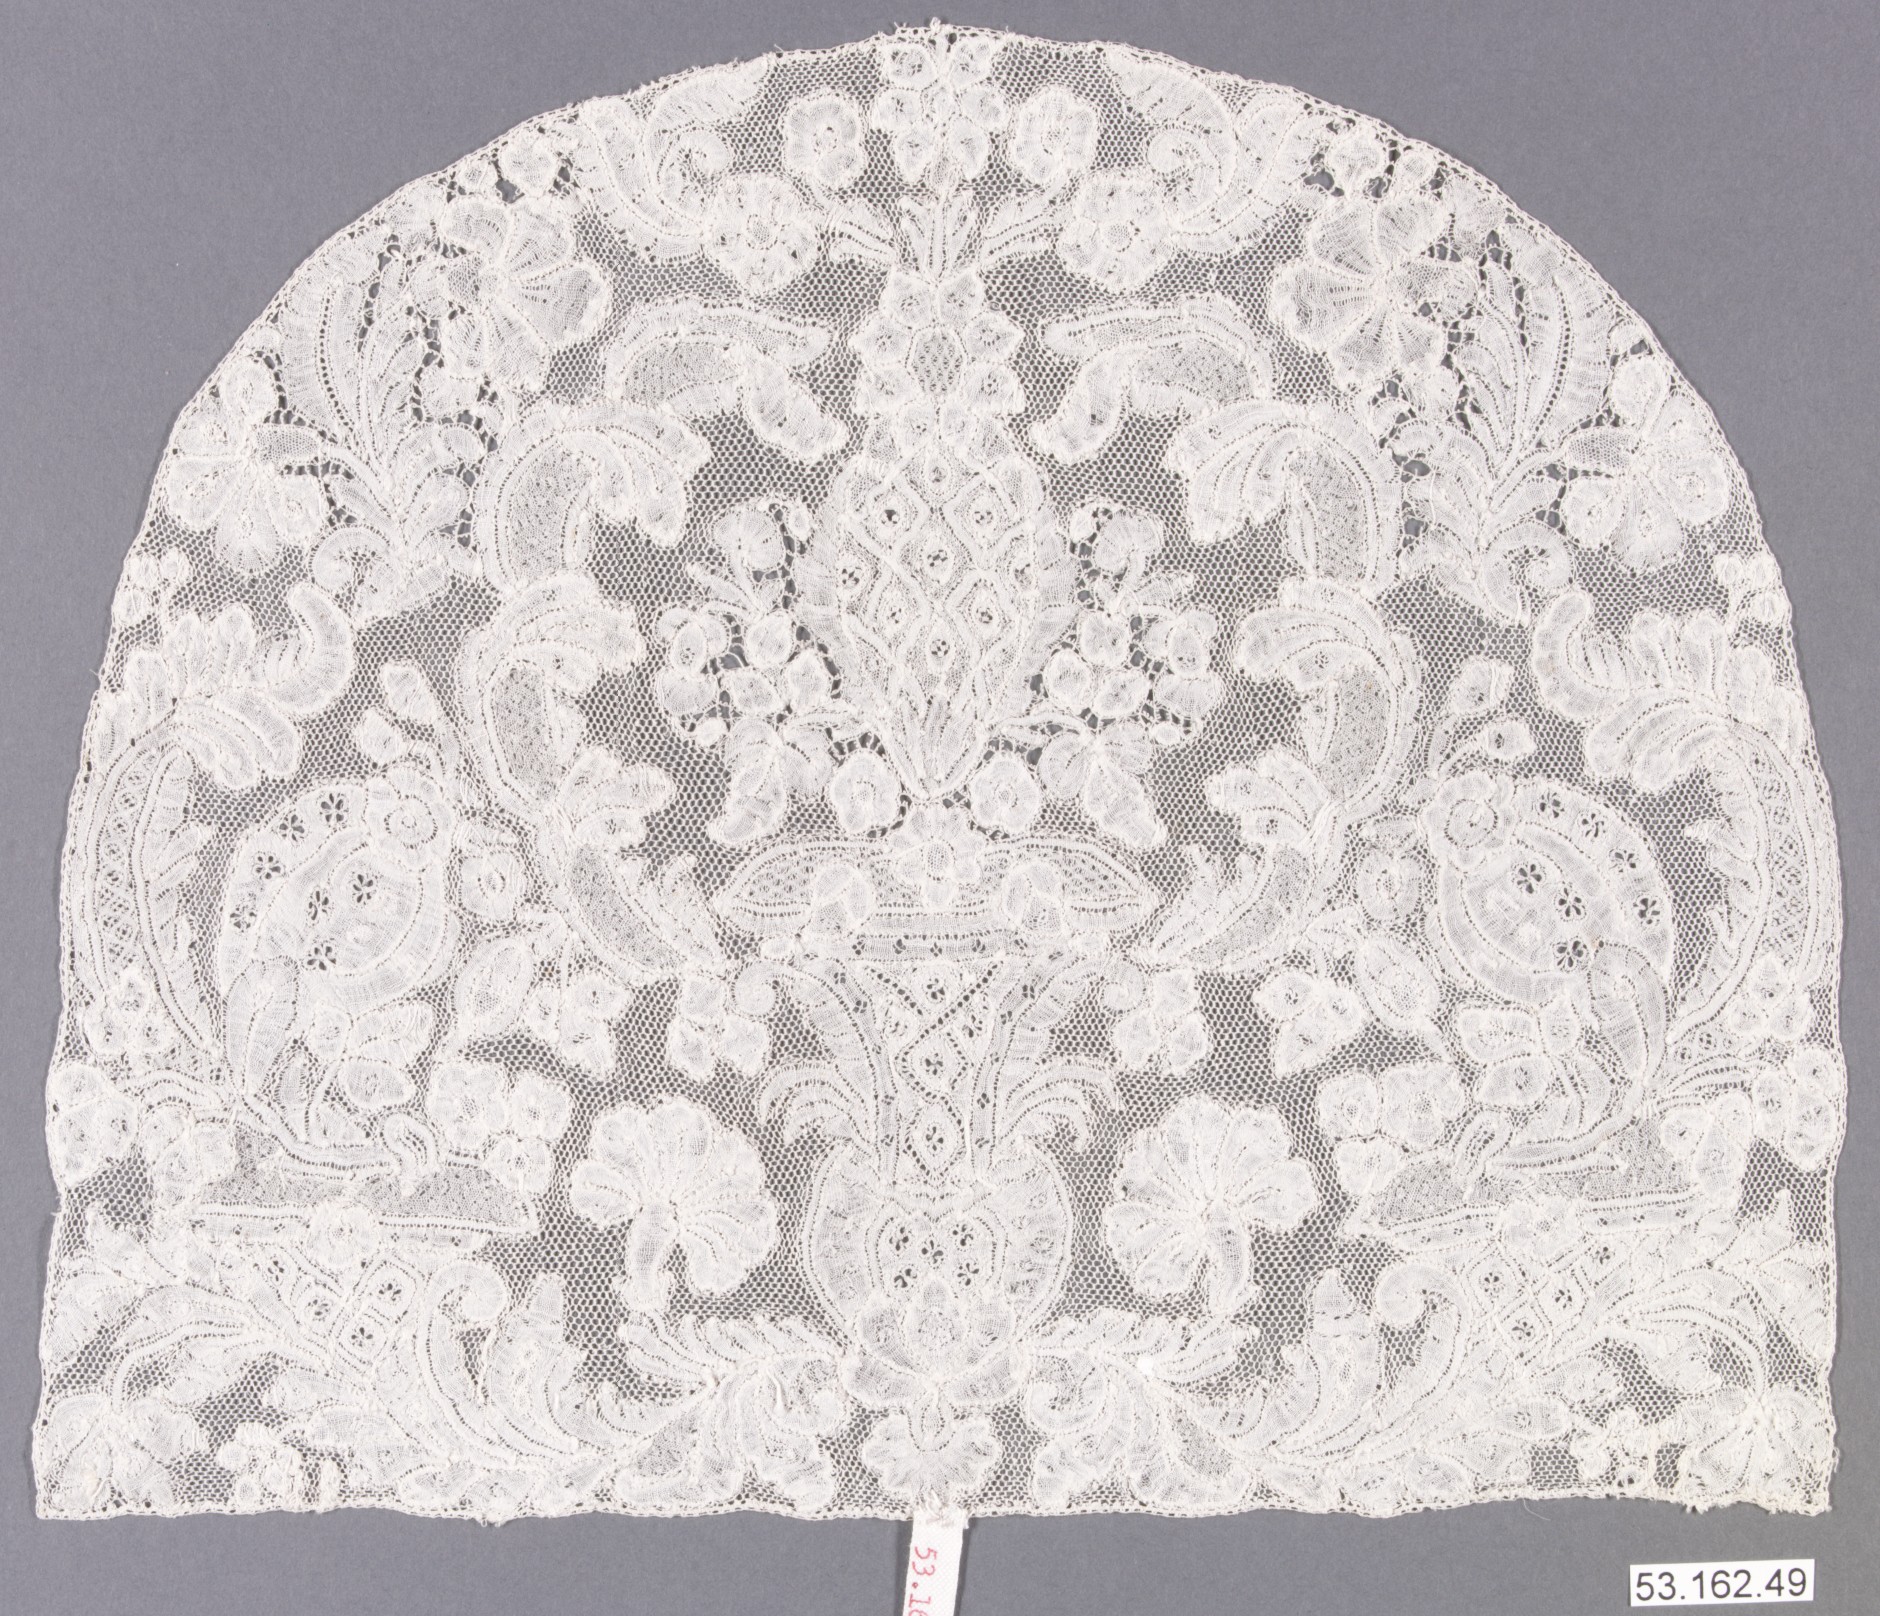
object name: cap crown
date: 1701-1800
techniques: lace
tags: flowers